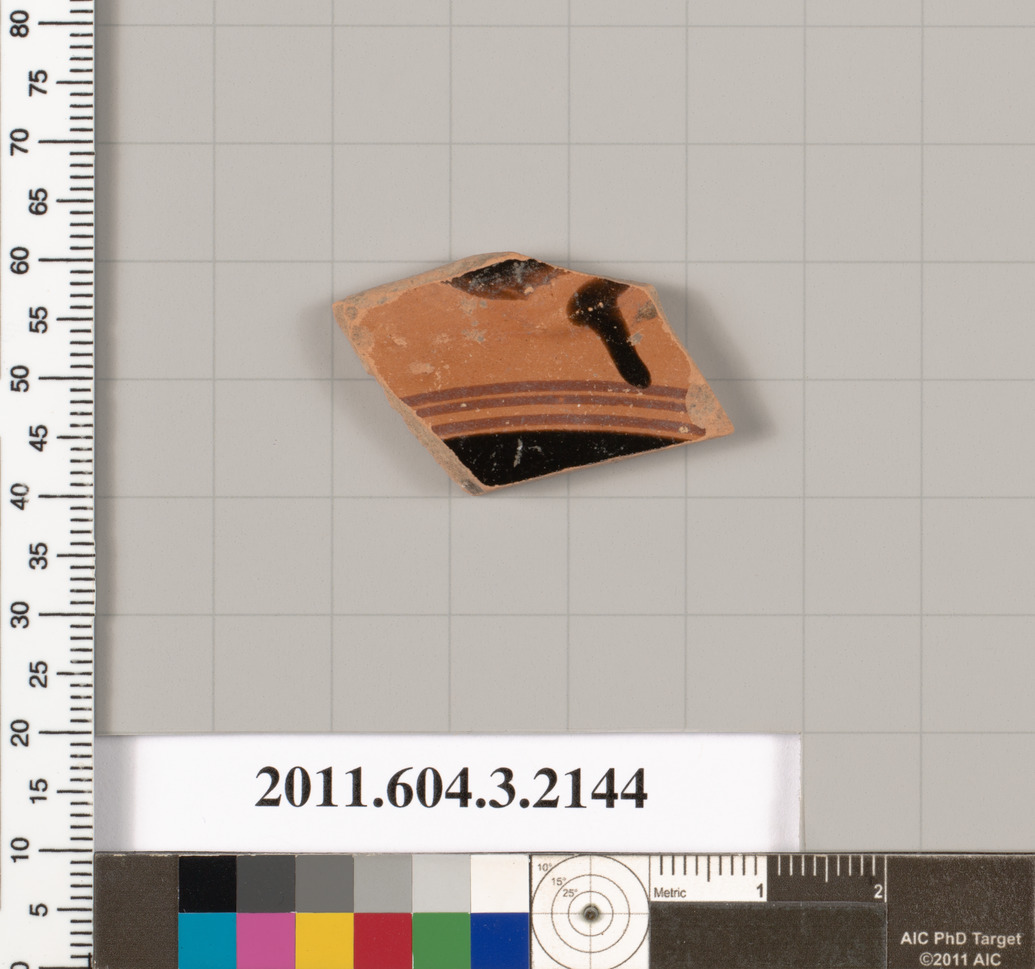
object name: kylix fragment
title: Terracotta fragment of a kylix (drinking cup)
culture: greek, attic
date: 534-468 BCE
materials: terracotta